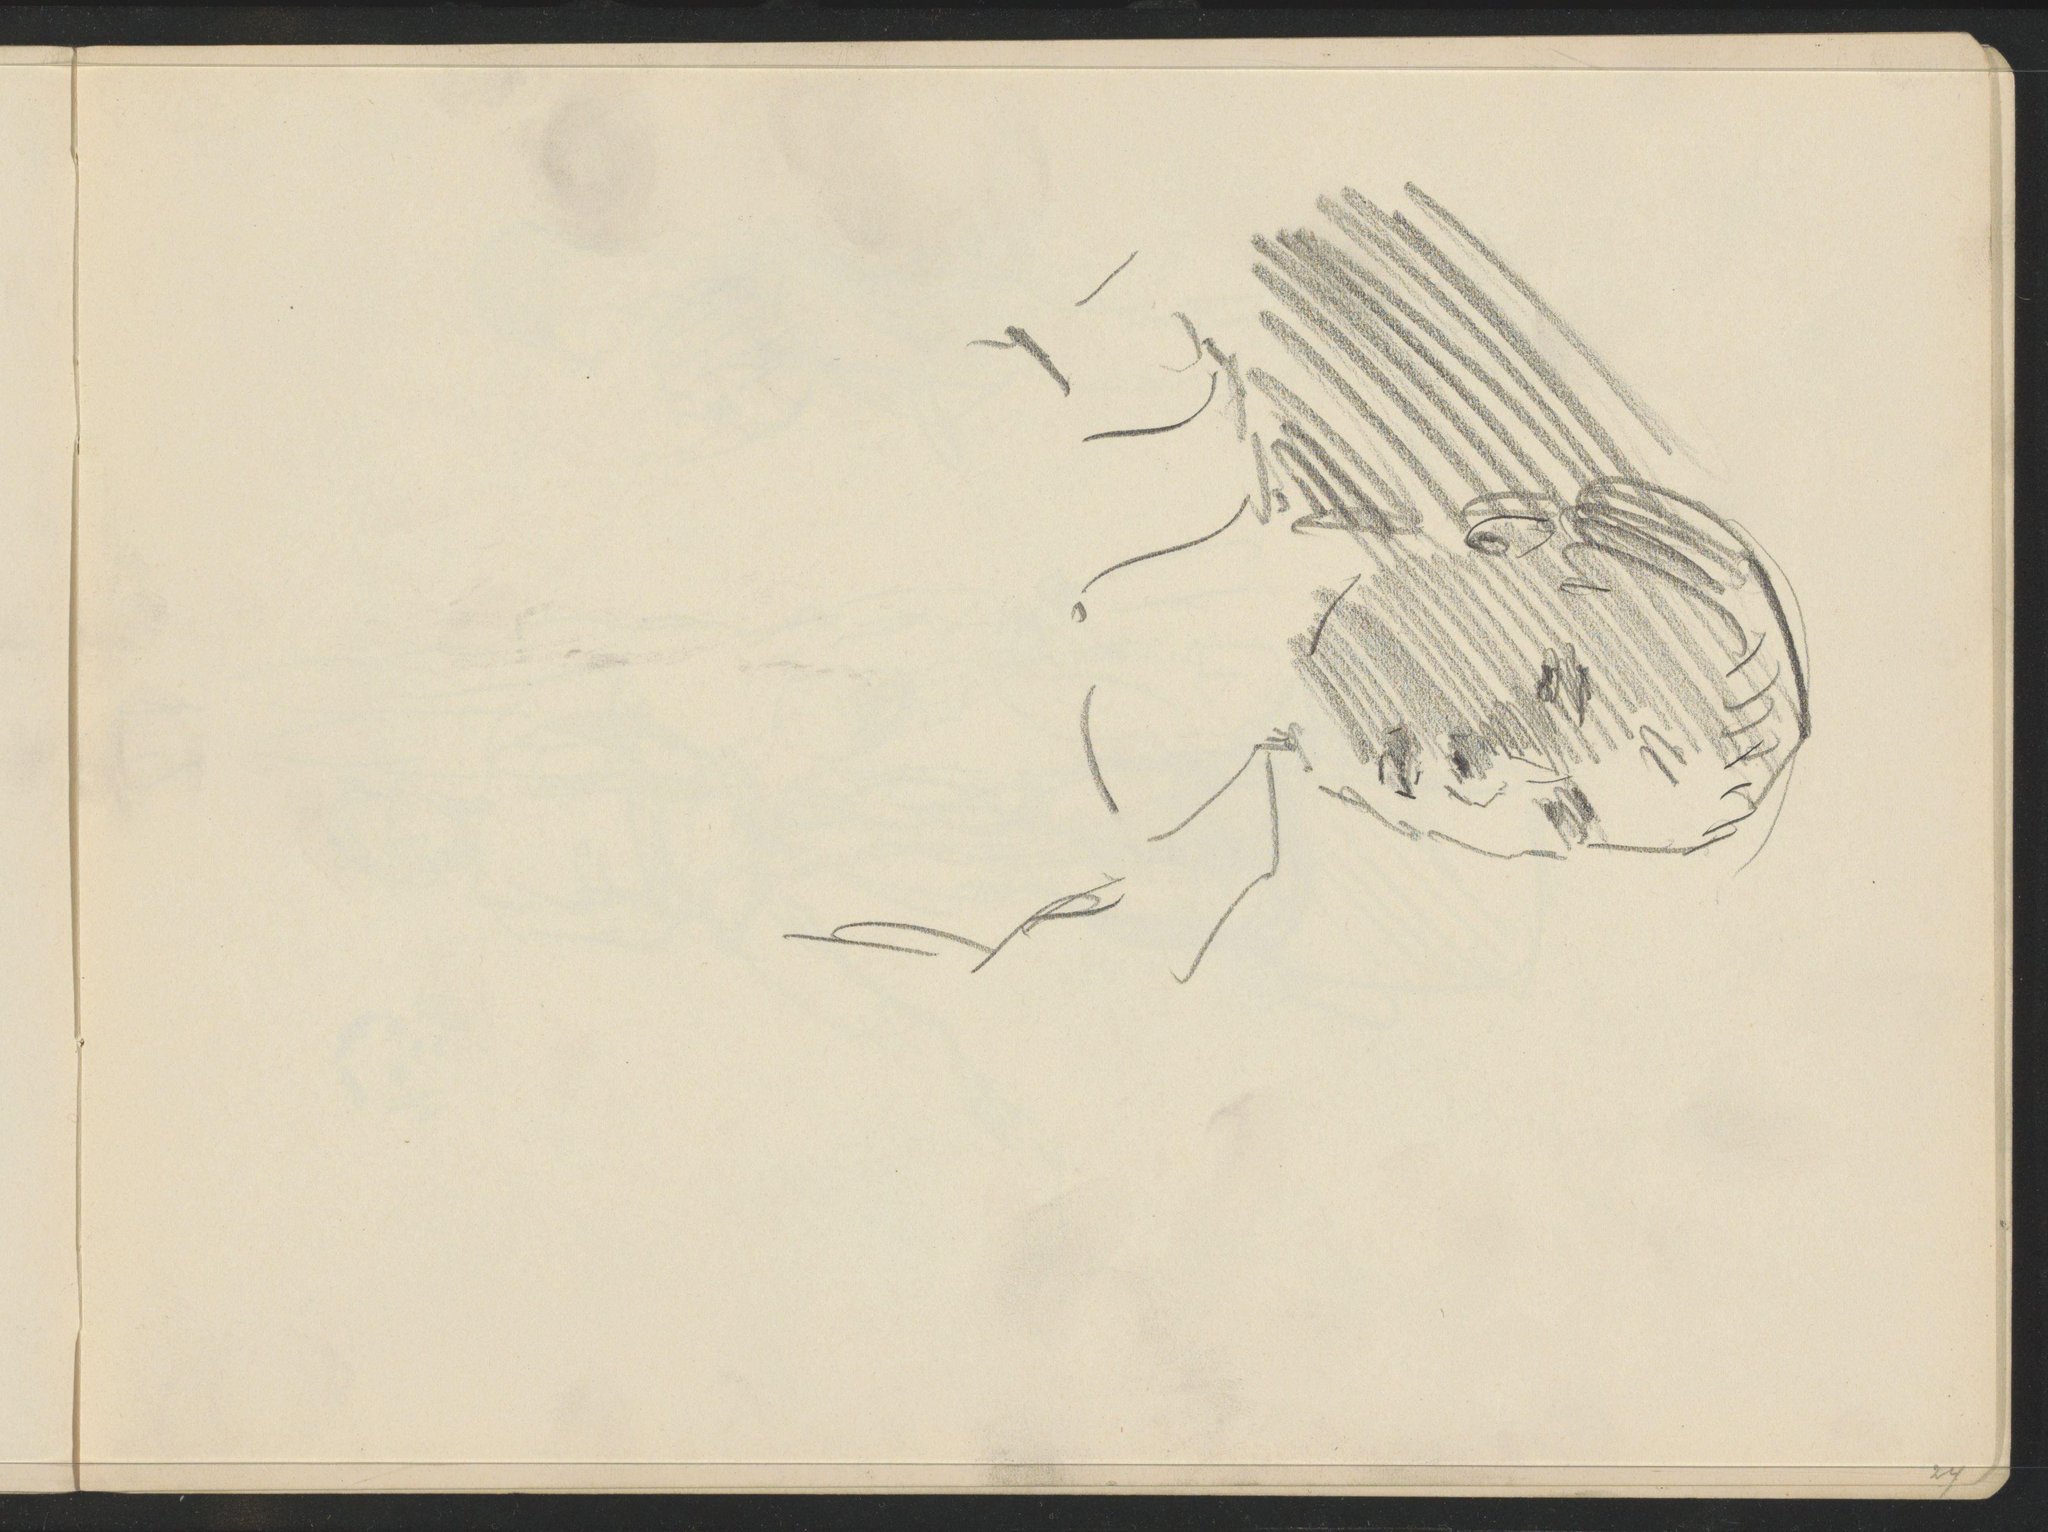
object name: sketchbook leaf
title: Figuurstudie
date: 1915-1934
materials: paper, pencil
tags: head (human)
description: Blad 24 recto uit schetsboek XVI met 32 bladen.